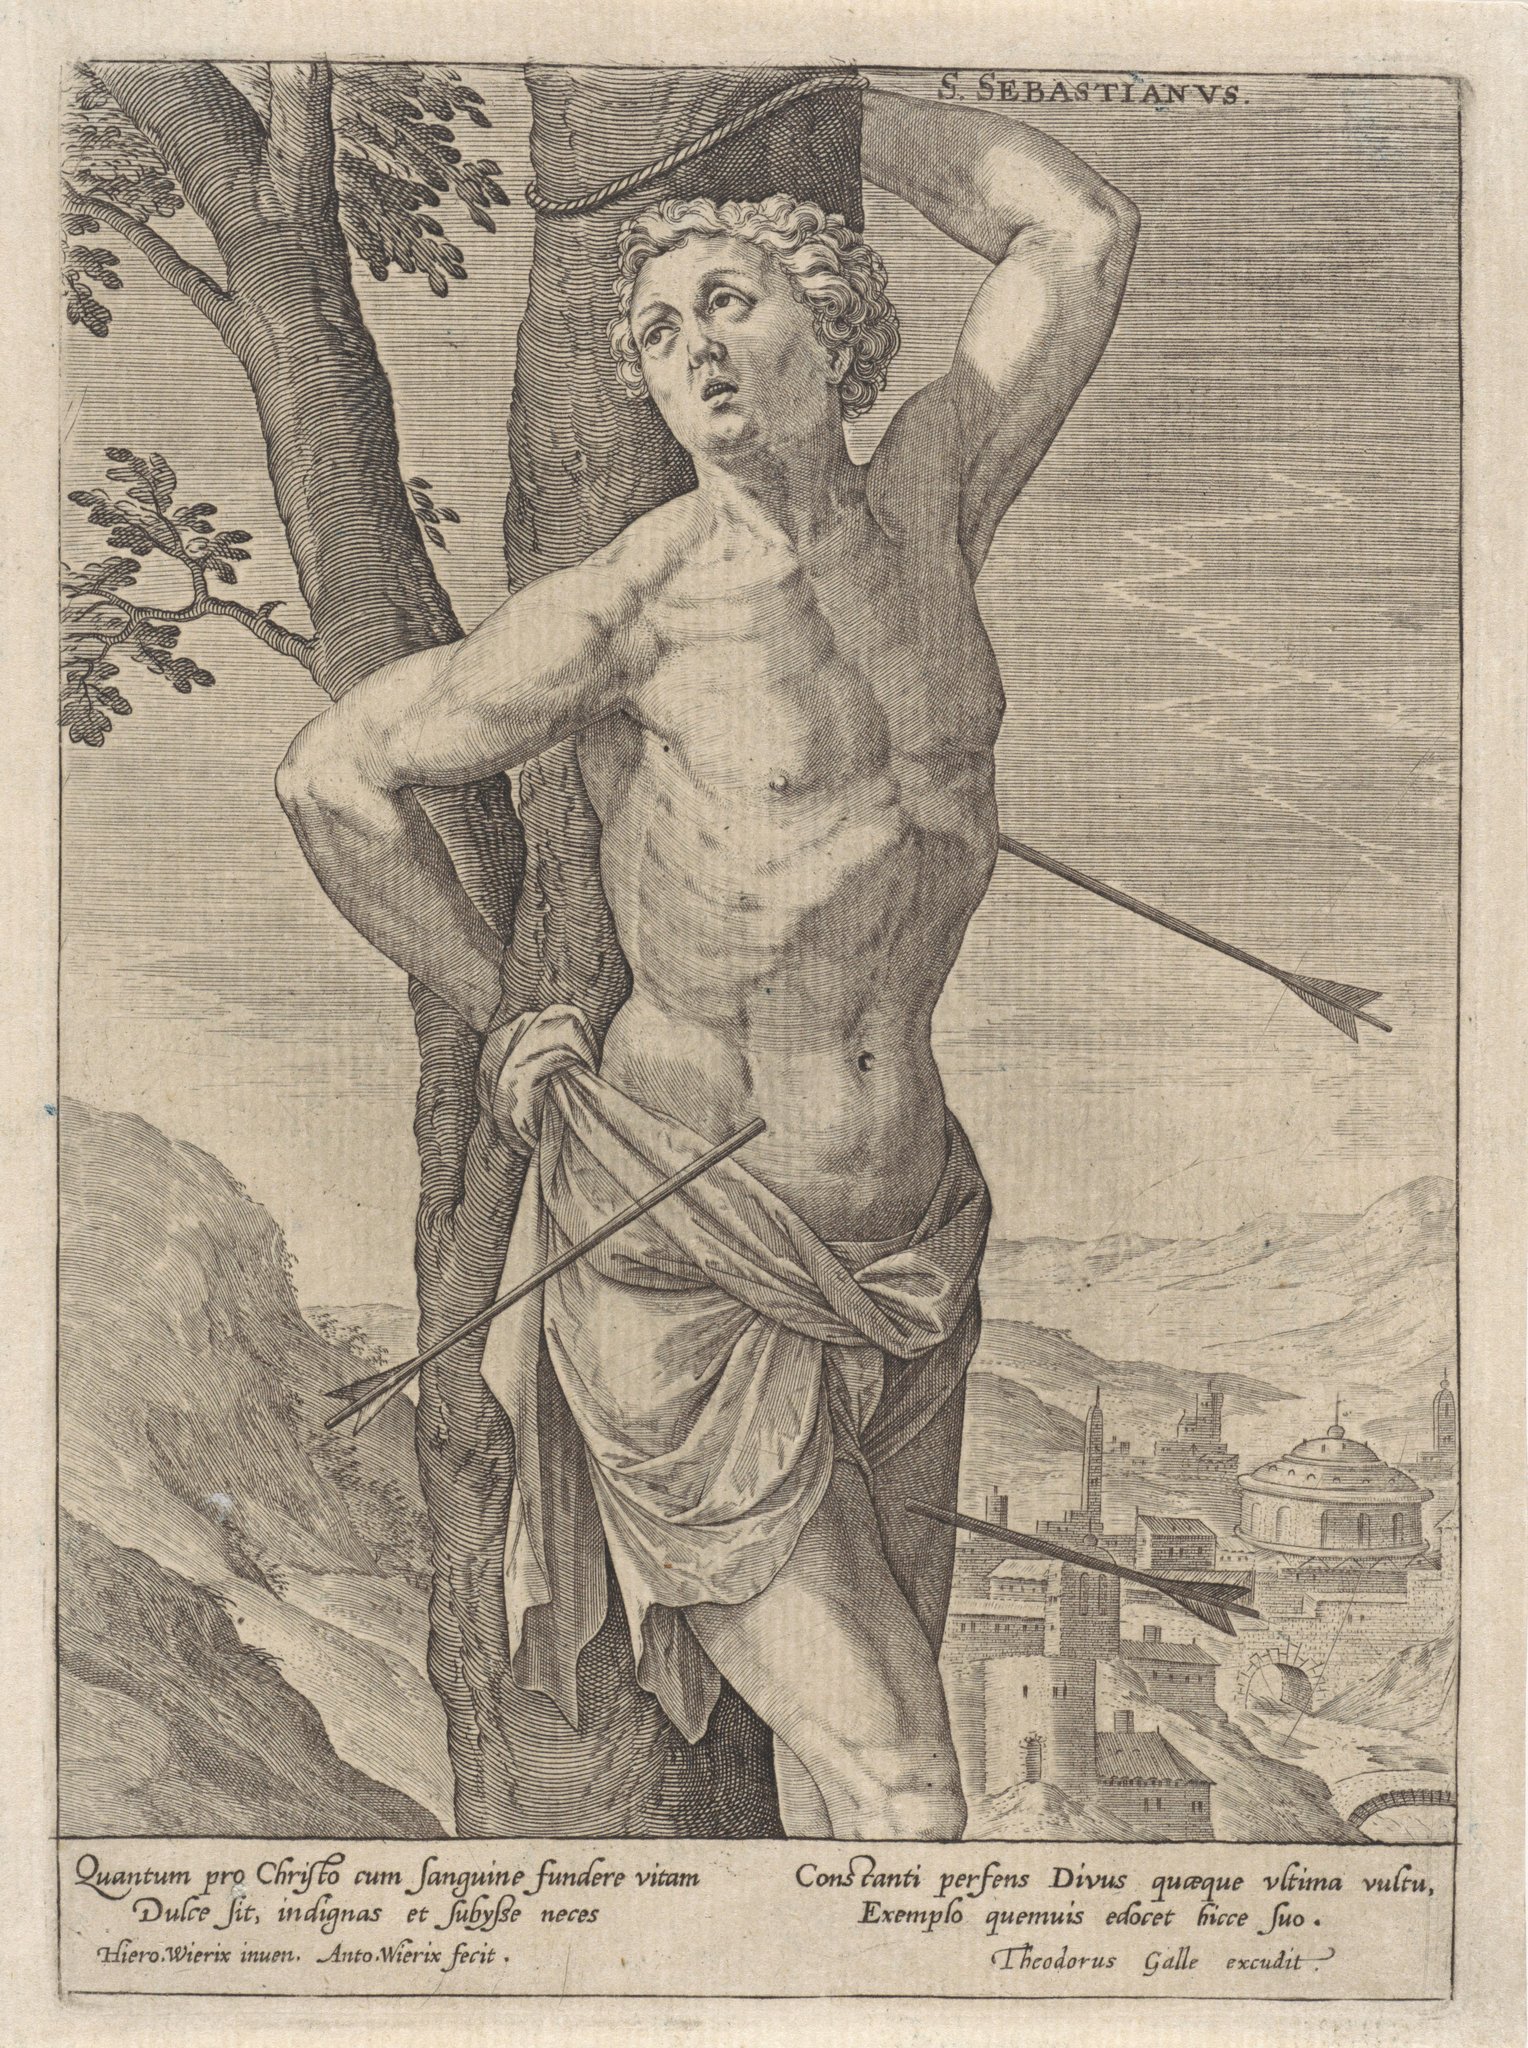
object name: print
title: S. Sebastianvs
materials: paper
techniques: engraving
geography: antwerp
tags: st. sebastian, tied to a tree or a pillar, is pierced by arrows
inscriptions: collector's mark: Lugt 2228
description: De heilige Sebastiaan is vastgebonden aan een boom. Pijlen hebben zich in zijn lichaam geboord. Op de achtergrond een gezicht op een stad. In de marge een vierregelig onderschrift, in twee kolommen, in het Latijn.